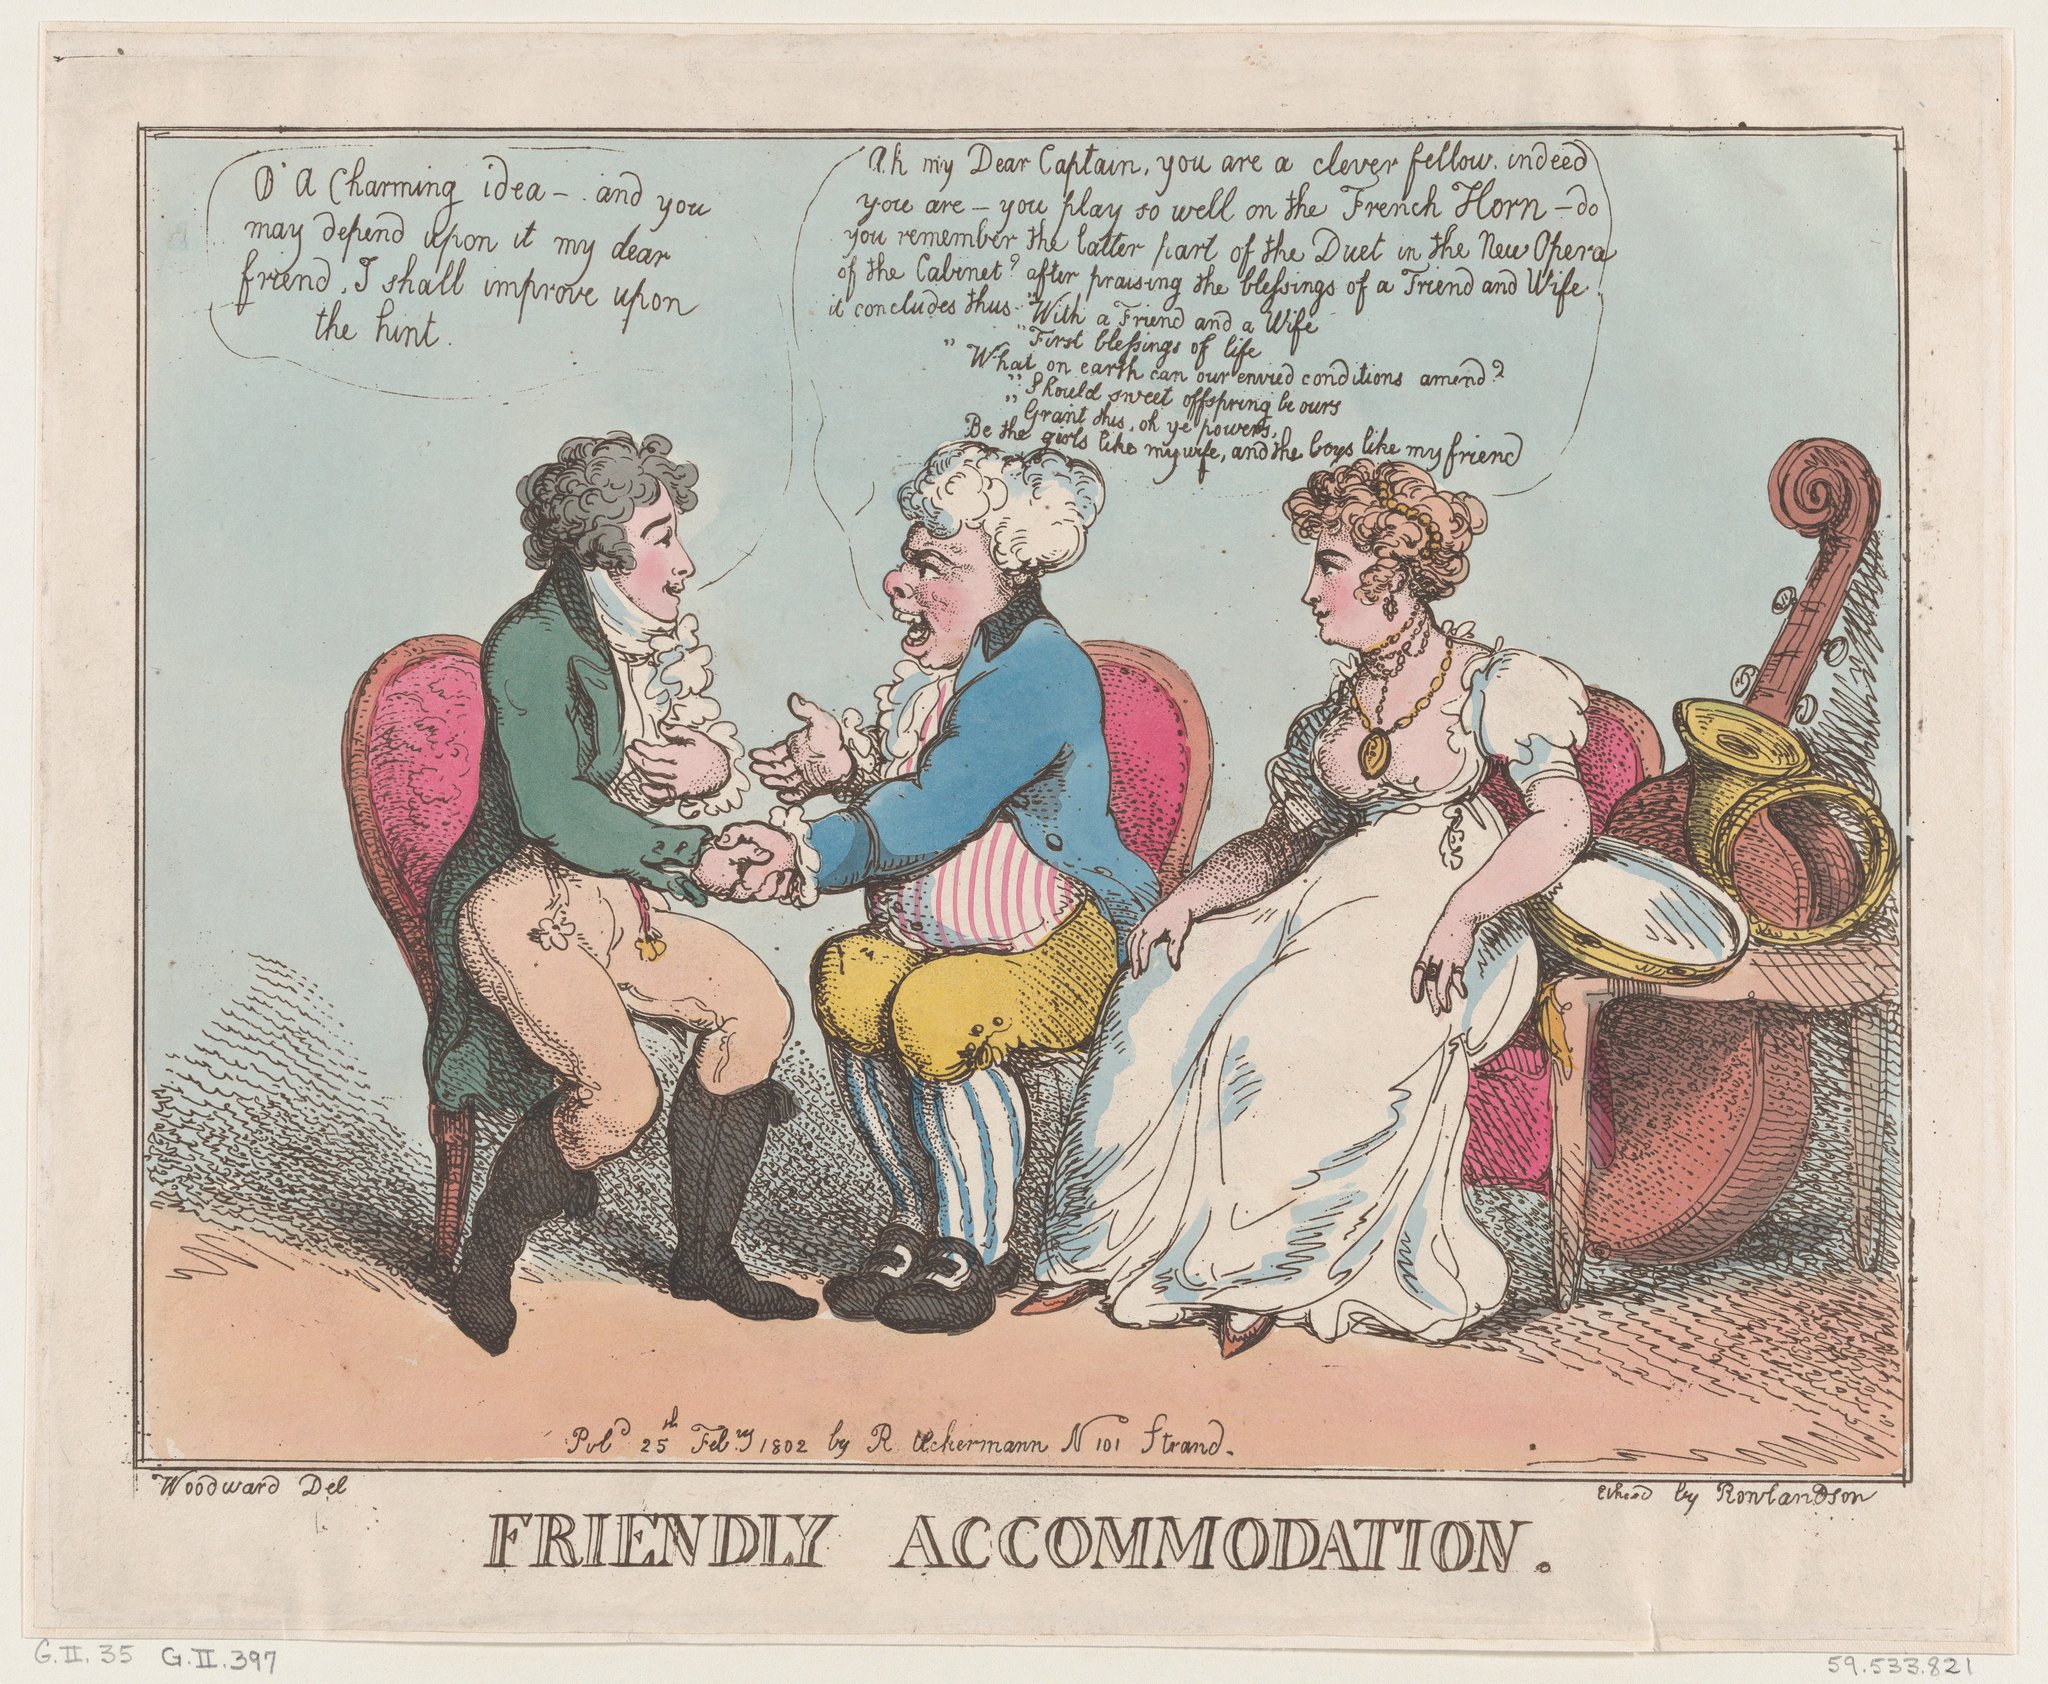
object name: print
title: Friendly Accommodation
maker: thomas rowlandson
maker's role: artist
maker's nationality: british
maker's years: 1757-1827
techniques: etching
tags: men,women